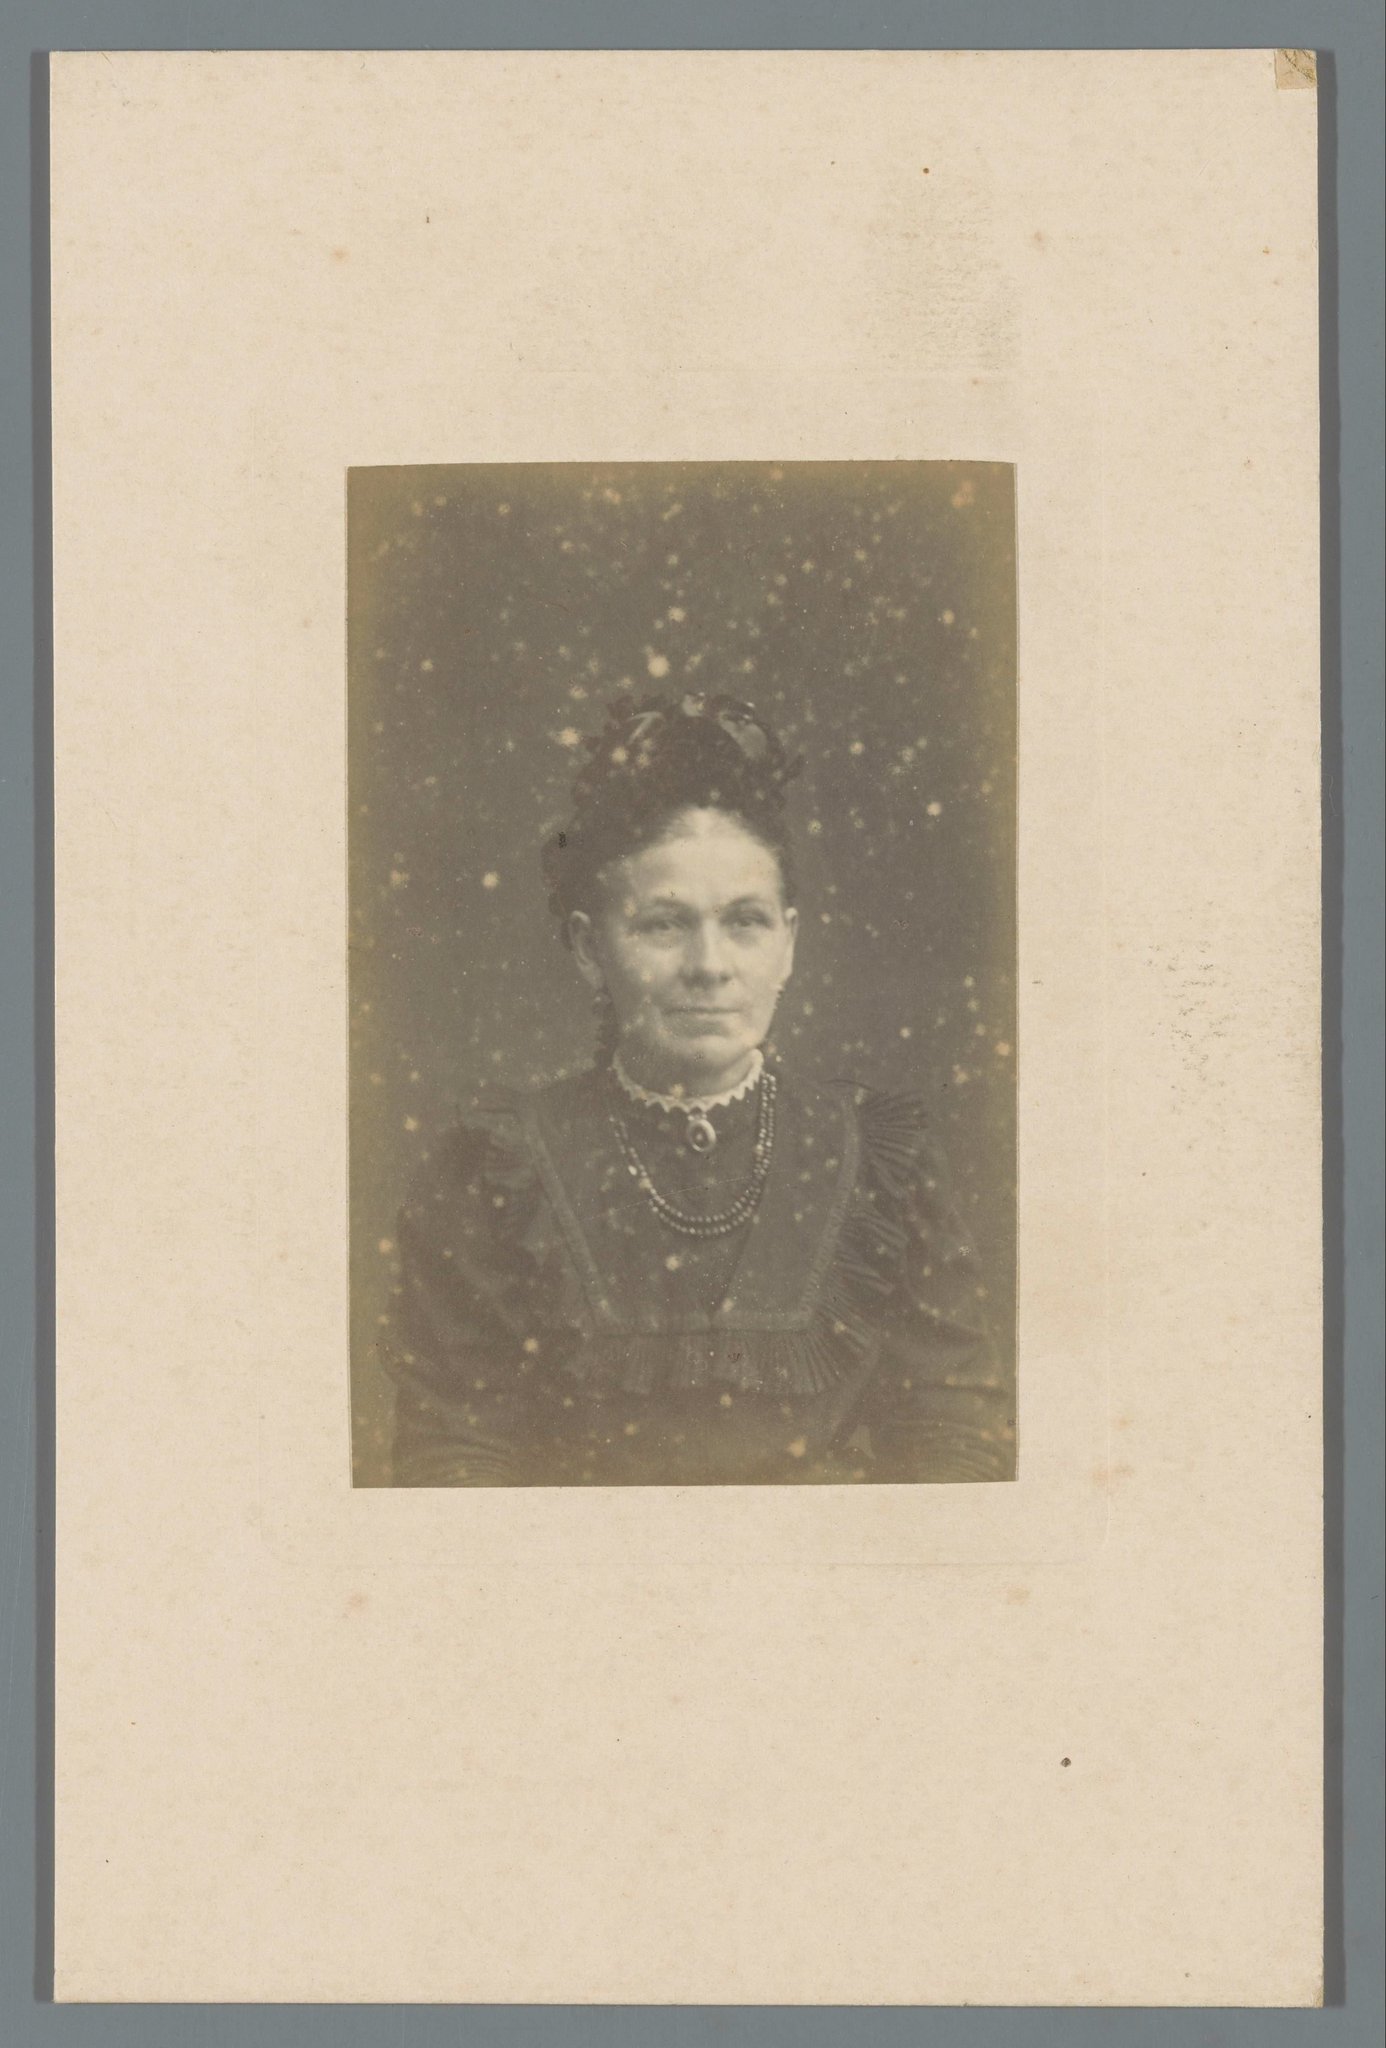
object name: photograph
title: Portret van Hiltje, mogelijk de vrouw van Klaas Kelderman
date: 1870-1900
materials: cardboard, photographic support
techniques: daylight paper print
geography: netherlands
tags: adult woman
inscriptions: inscription: ‘Klaas Kelderman's vrouw? Hiltje’